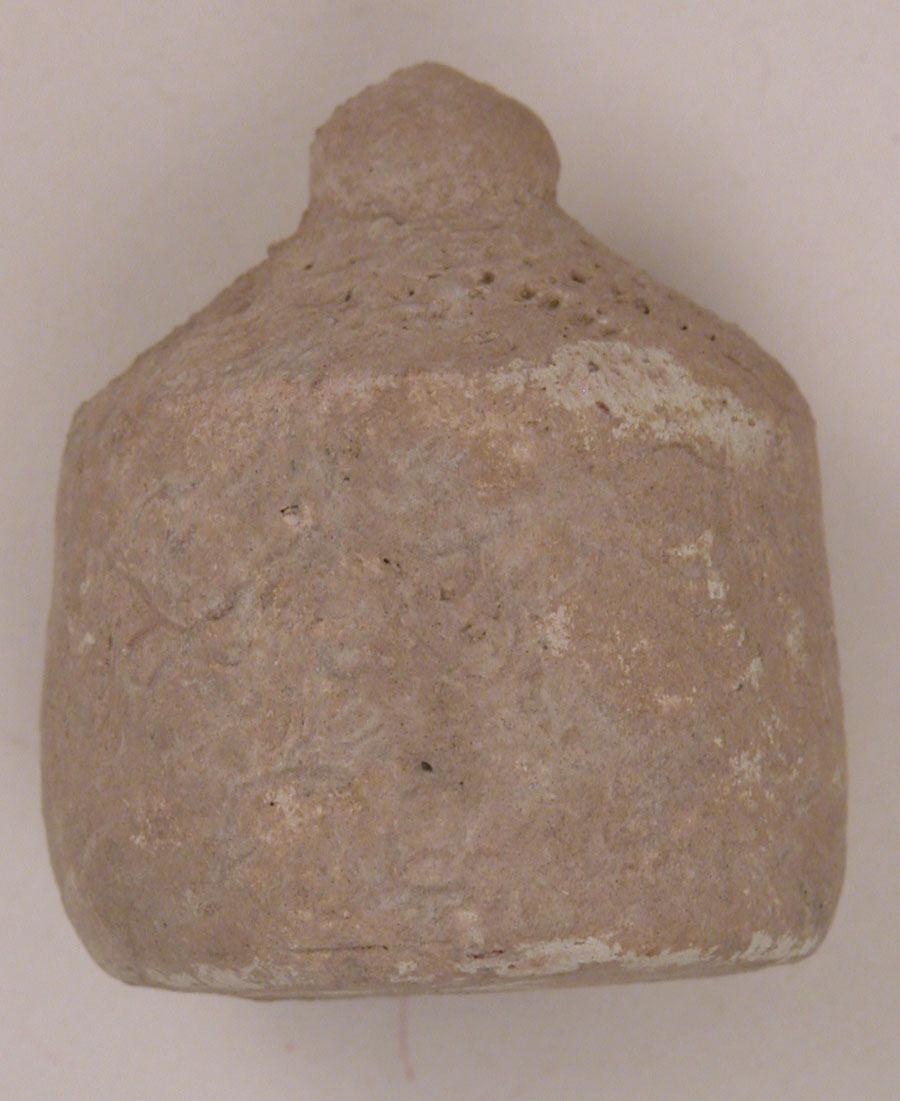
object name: chess piece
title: Chess Piece, Pawn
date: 701-1100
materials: earthenware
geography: western islamic lands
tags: chess,games